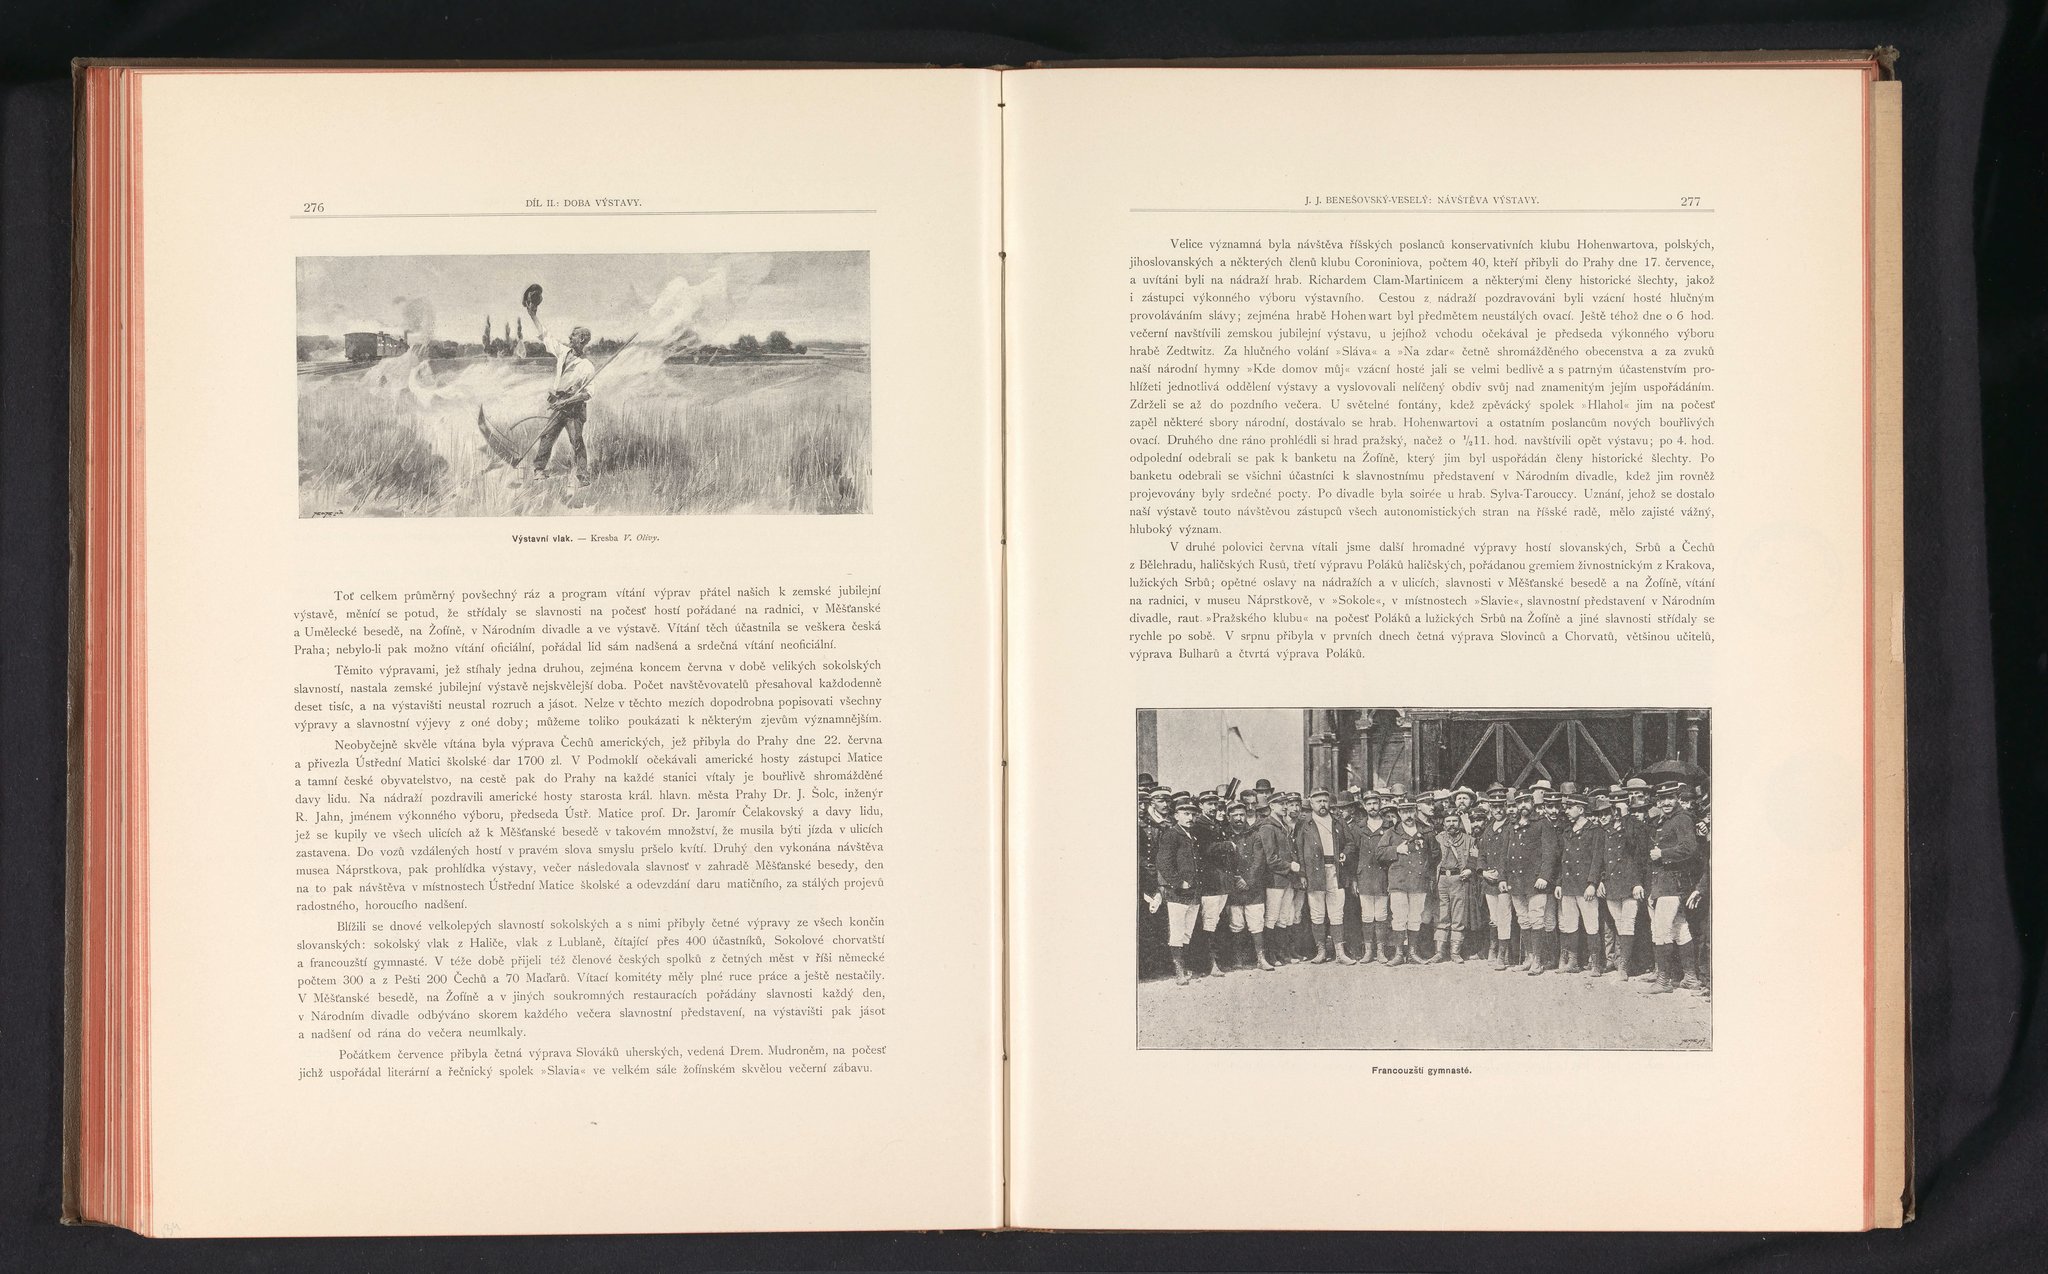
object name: photomechanical print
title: Výstavní vlak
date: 1891-1893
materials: paper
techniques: autotype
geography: prague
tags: agricultural implements: scythe, passenger train, farmers